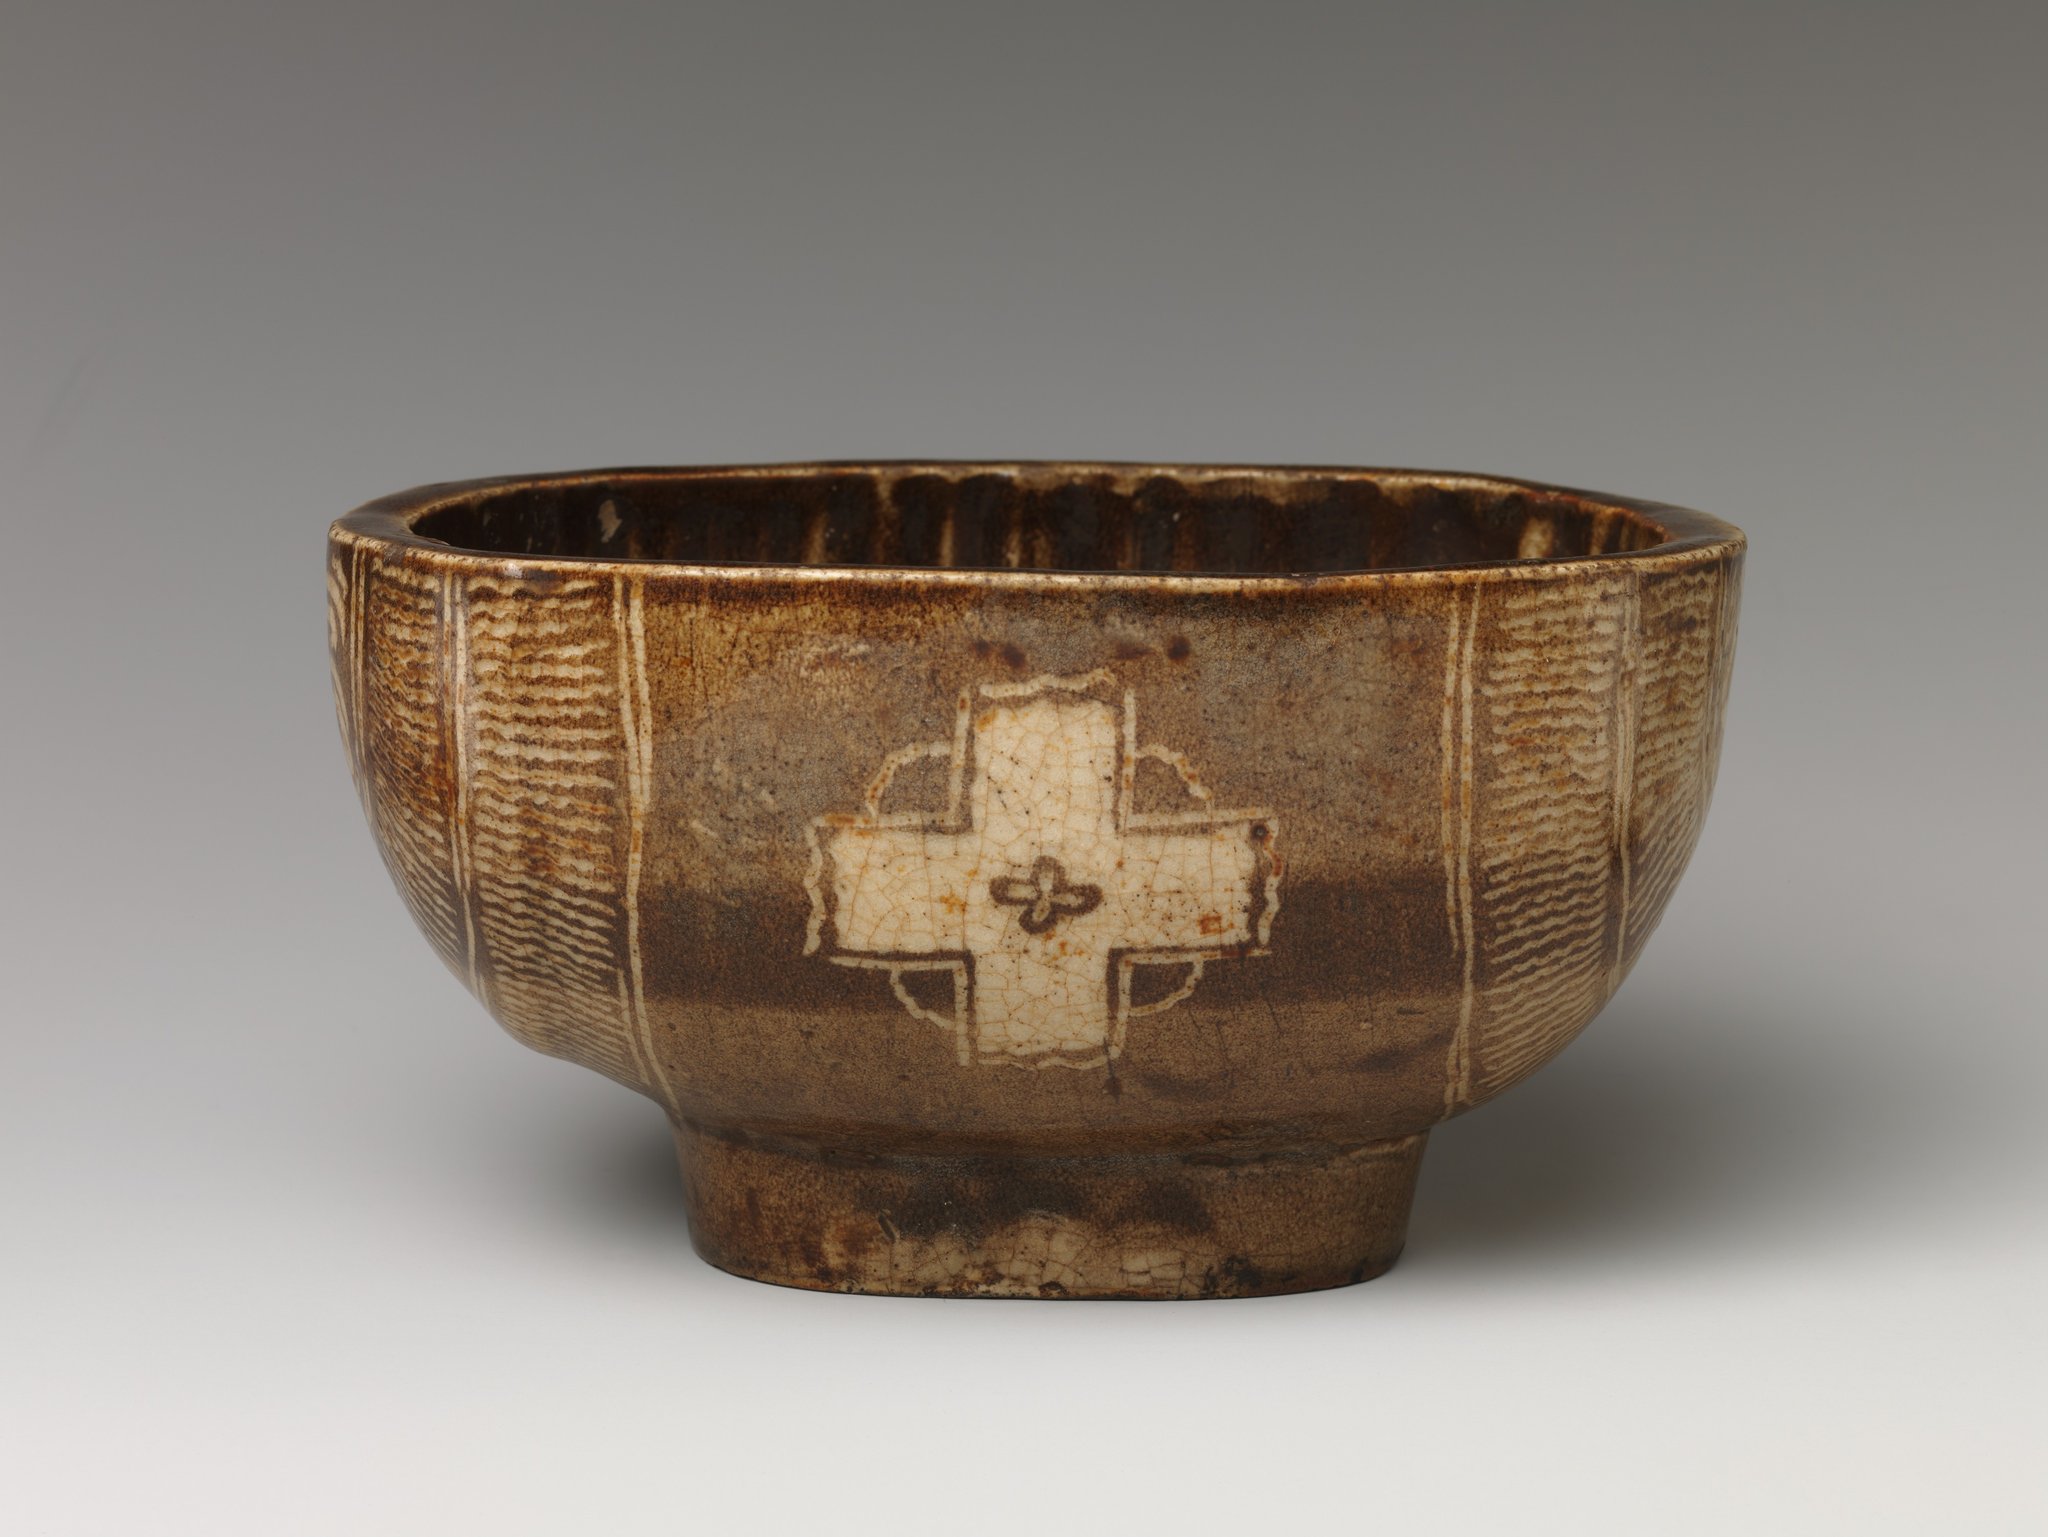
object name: bowl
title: Tea Bowl with Cross Design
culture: japanese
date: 1801-1833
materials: clay, glaze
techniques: inlay